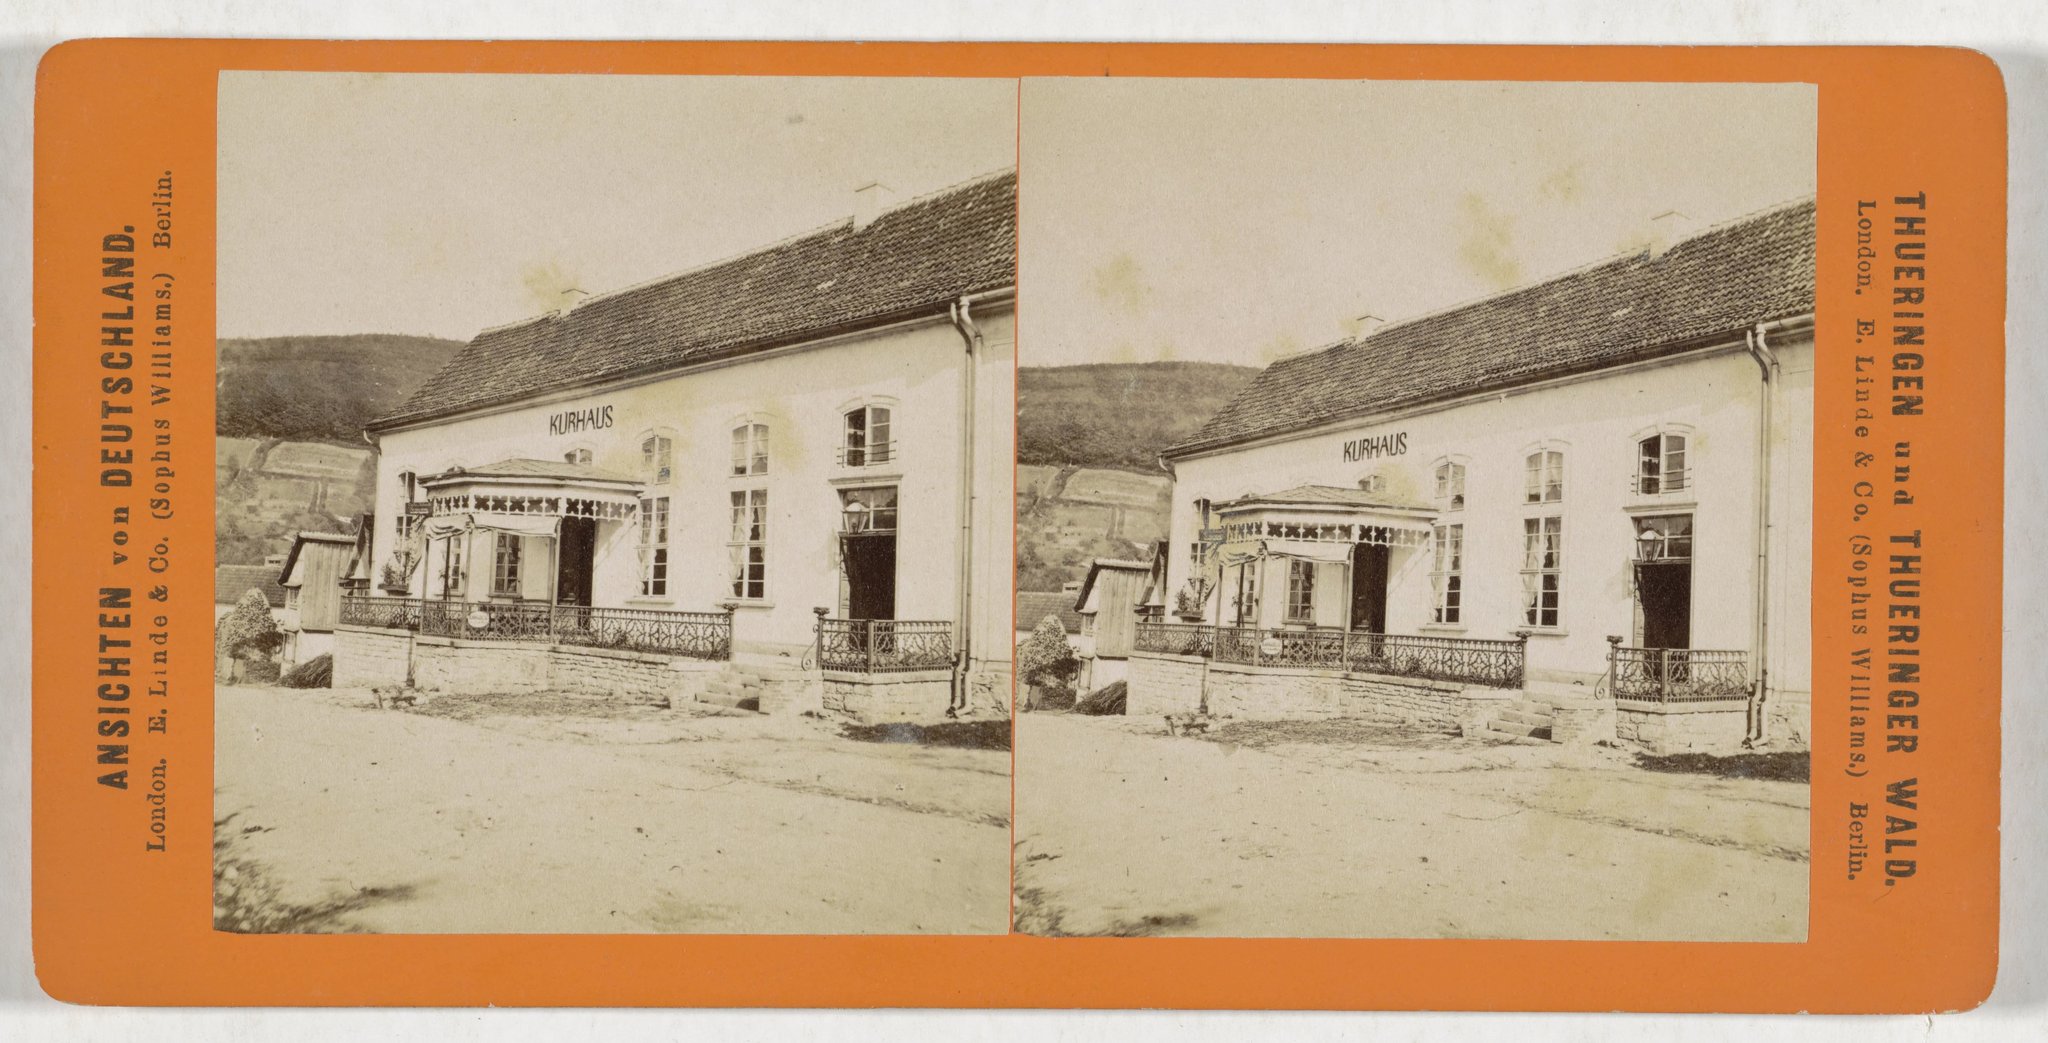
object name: stereograph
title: Kurhaus in Ruhla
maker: hermann selle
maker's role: fotograaf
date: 1868-1890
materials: cardboard, paper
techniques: albumen print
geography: london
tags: hotel, hostelry, inn